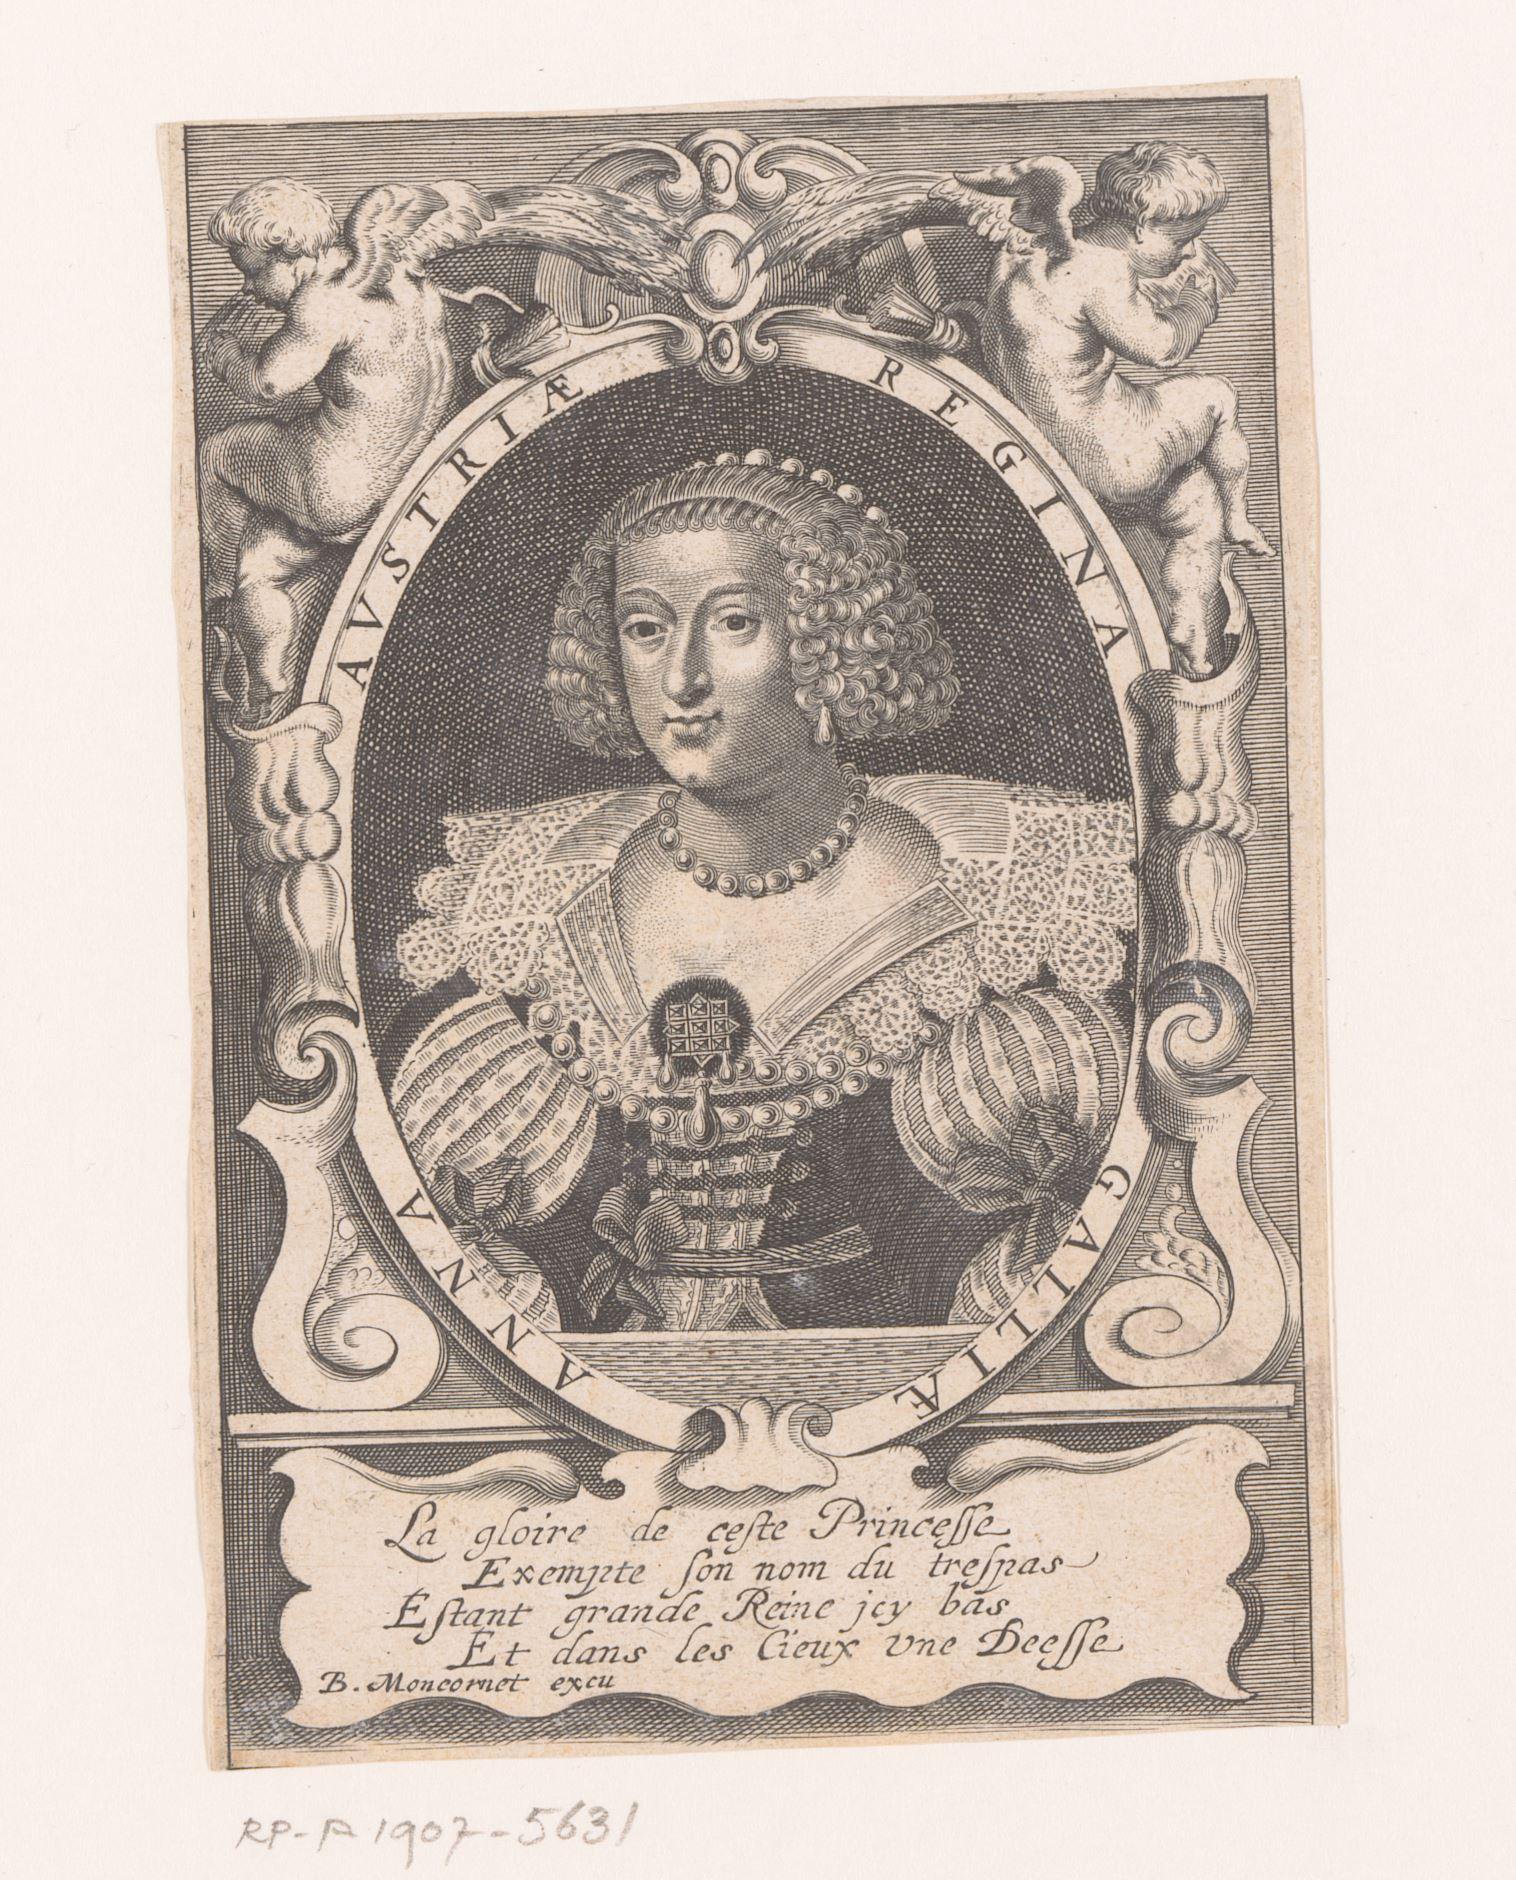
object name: print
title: Portret van Anna van Oostenrijk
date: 1610-1668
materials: paper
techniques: engraving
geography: paris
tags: paris, anna van oostenrijk (koningin van frankrijk), historical persons - bb - woman, ruler, sovereign - bb - female ruler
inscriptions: collector's mark: Lugt 2228